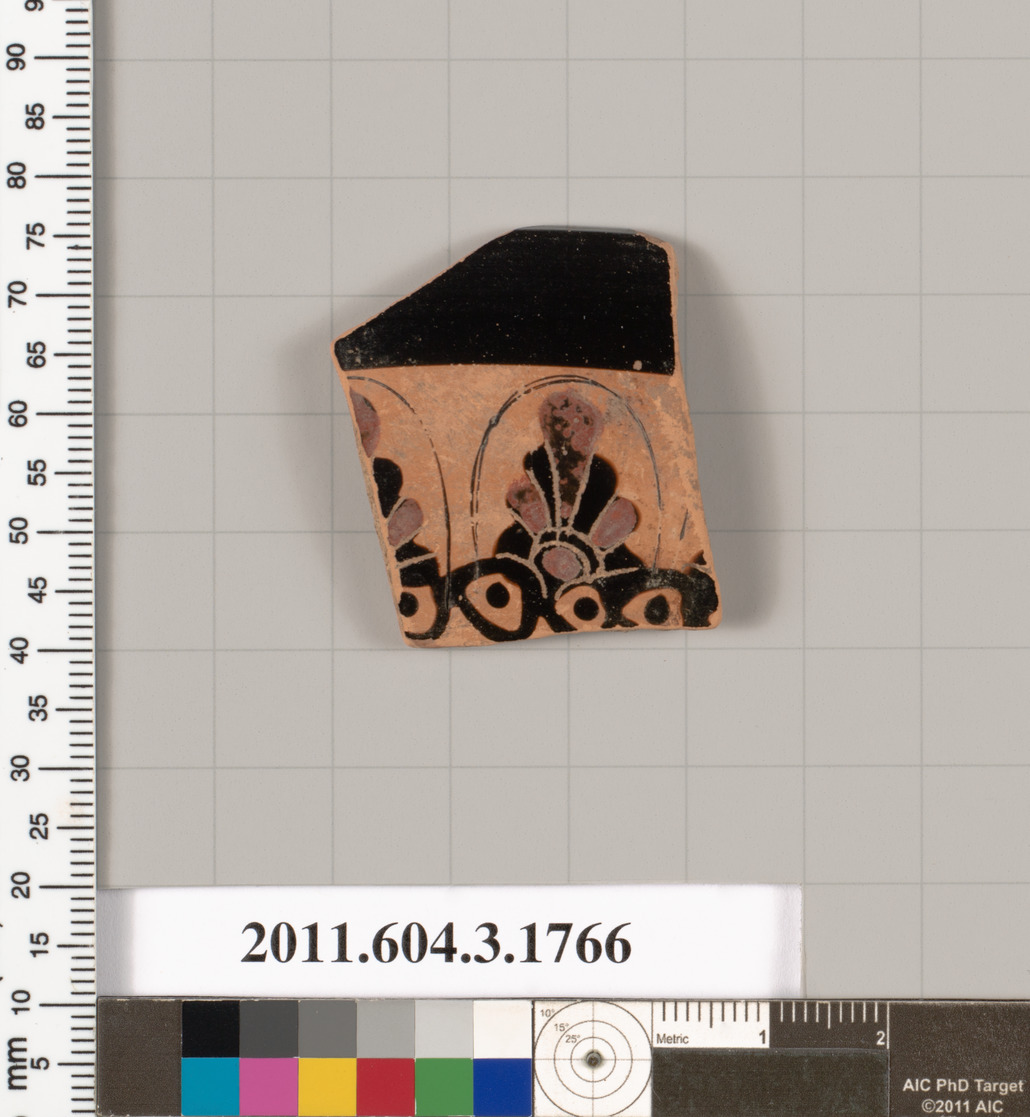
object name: kylix fragment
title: Terracotta fragment of a kylix: Band cup (drinking cup)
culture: greek, attic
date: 550-526 BCE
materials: terracotta